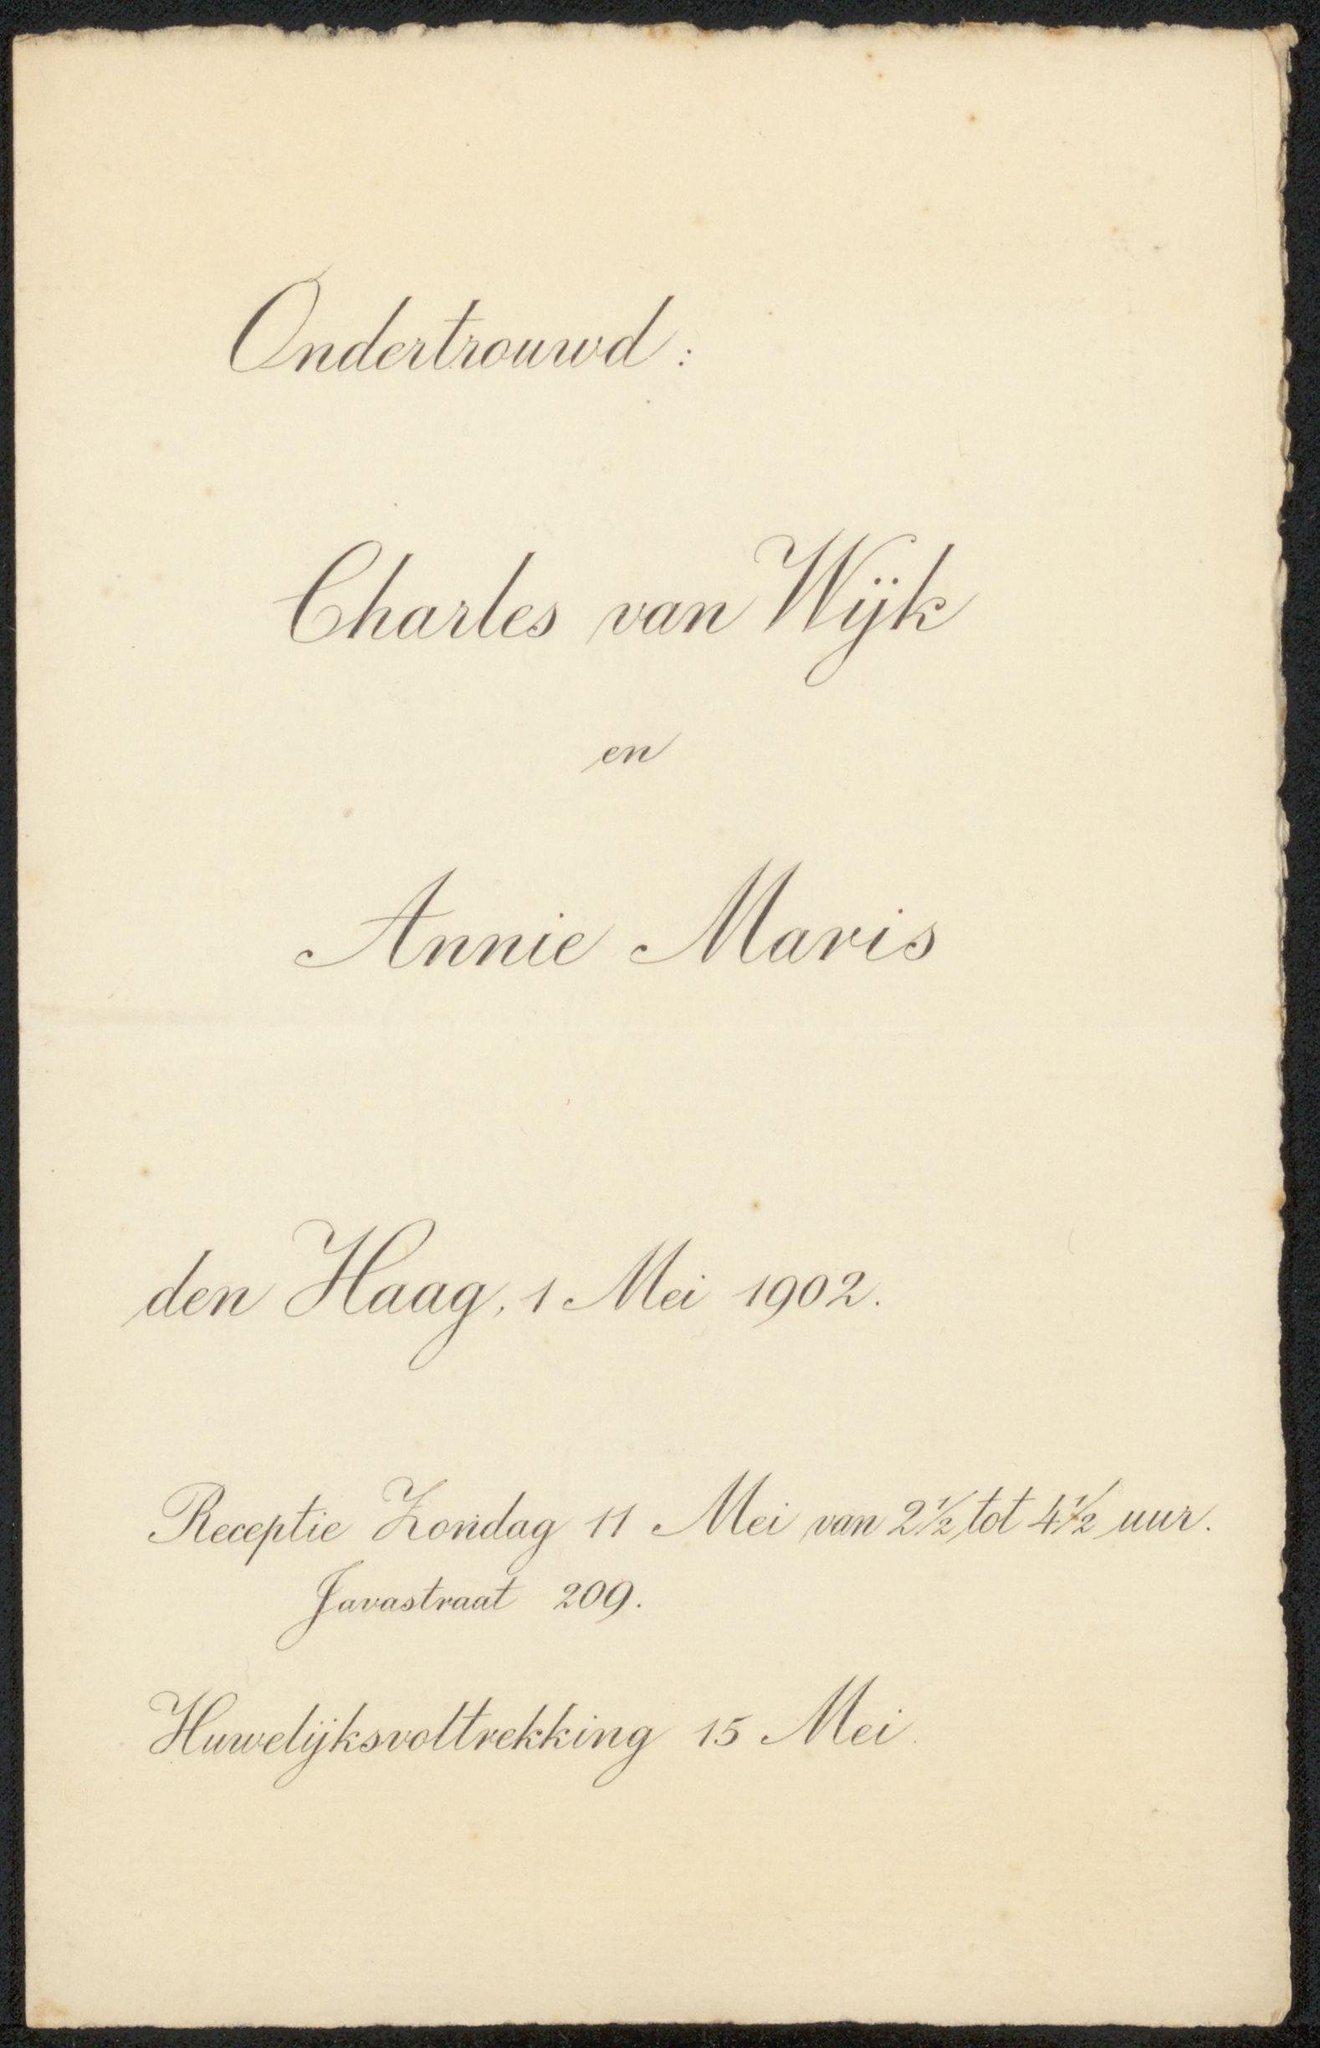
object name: wedding announcement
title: Ondertrouwaankondiging aan Philip Zilcken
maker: Anonymous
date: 1902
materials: paper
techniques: printing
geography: the hague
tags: the hague, sculptor, charles van wijk, amsterdam, annie maris, painter, draughtsman, philip zilcken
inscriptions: watermark, collector's mark: ‘RPK’